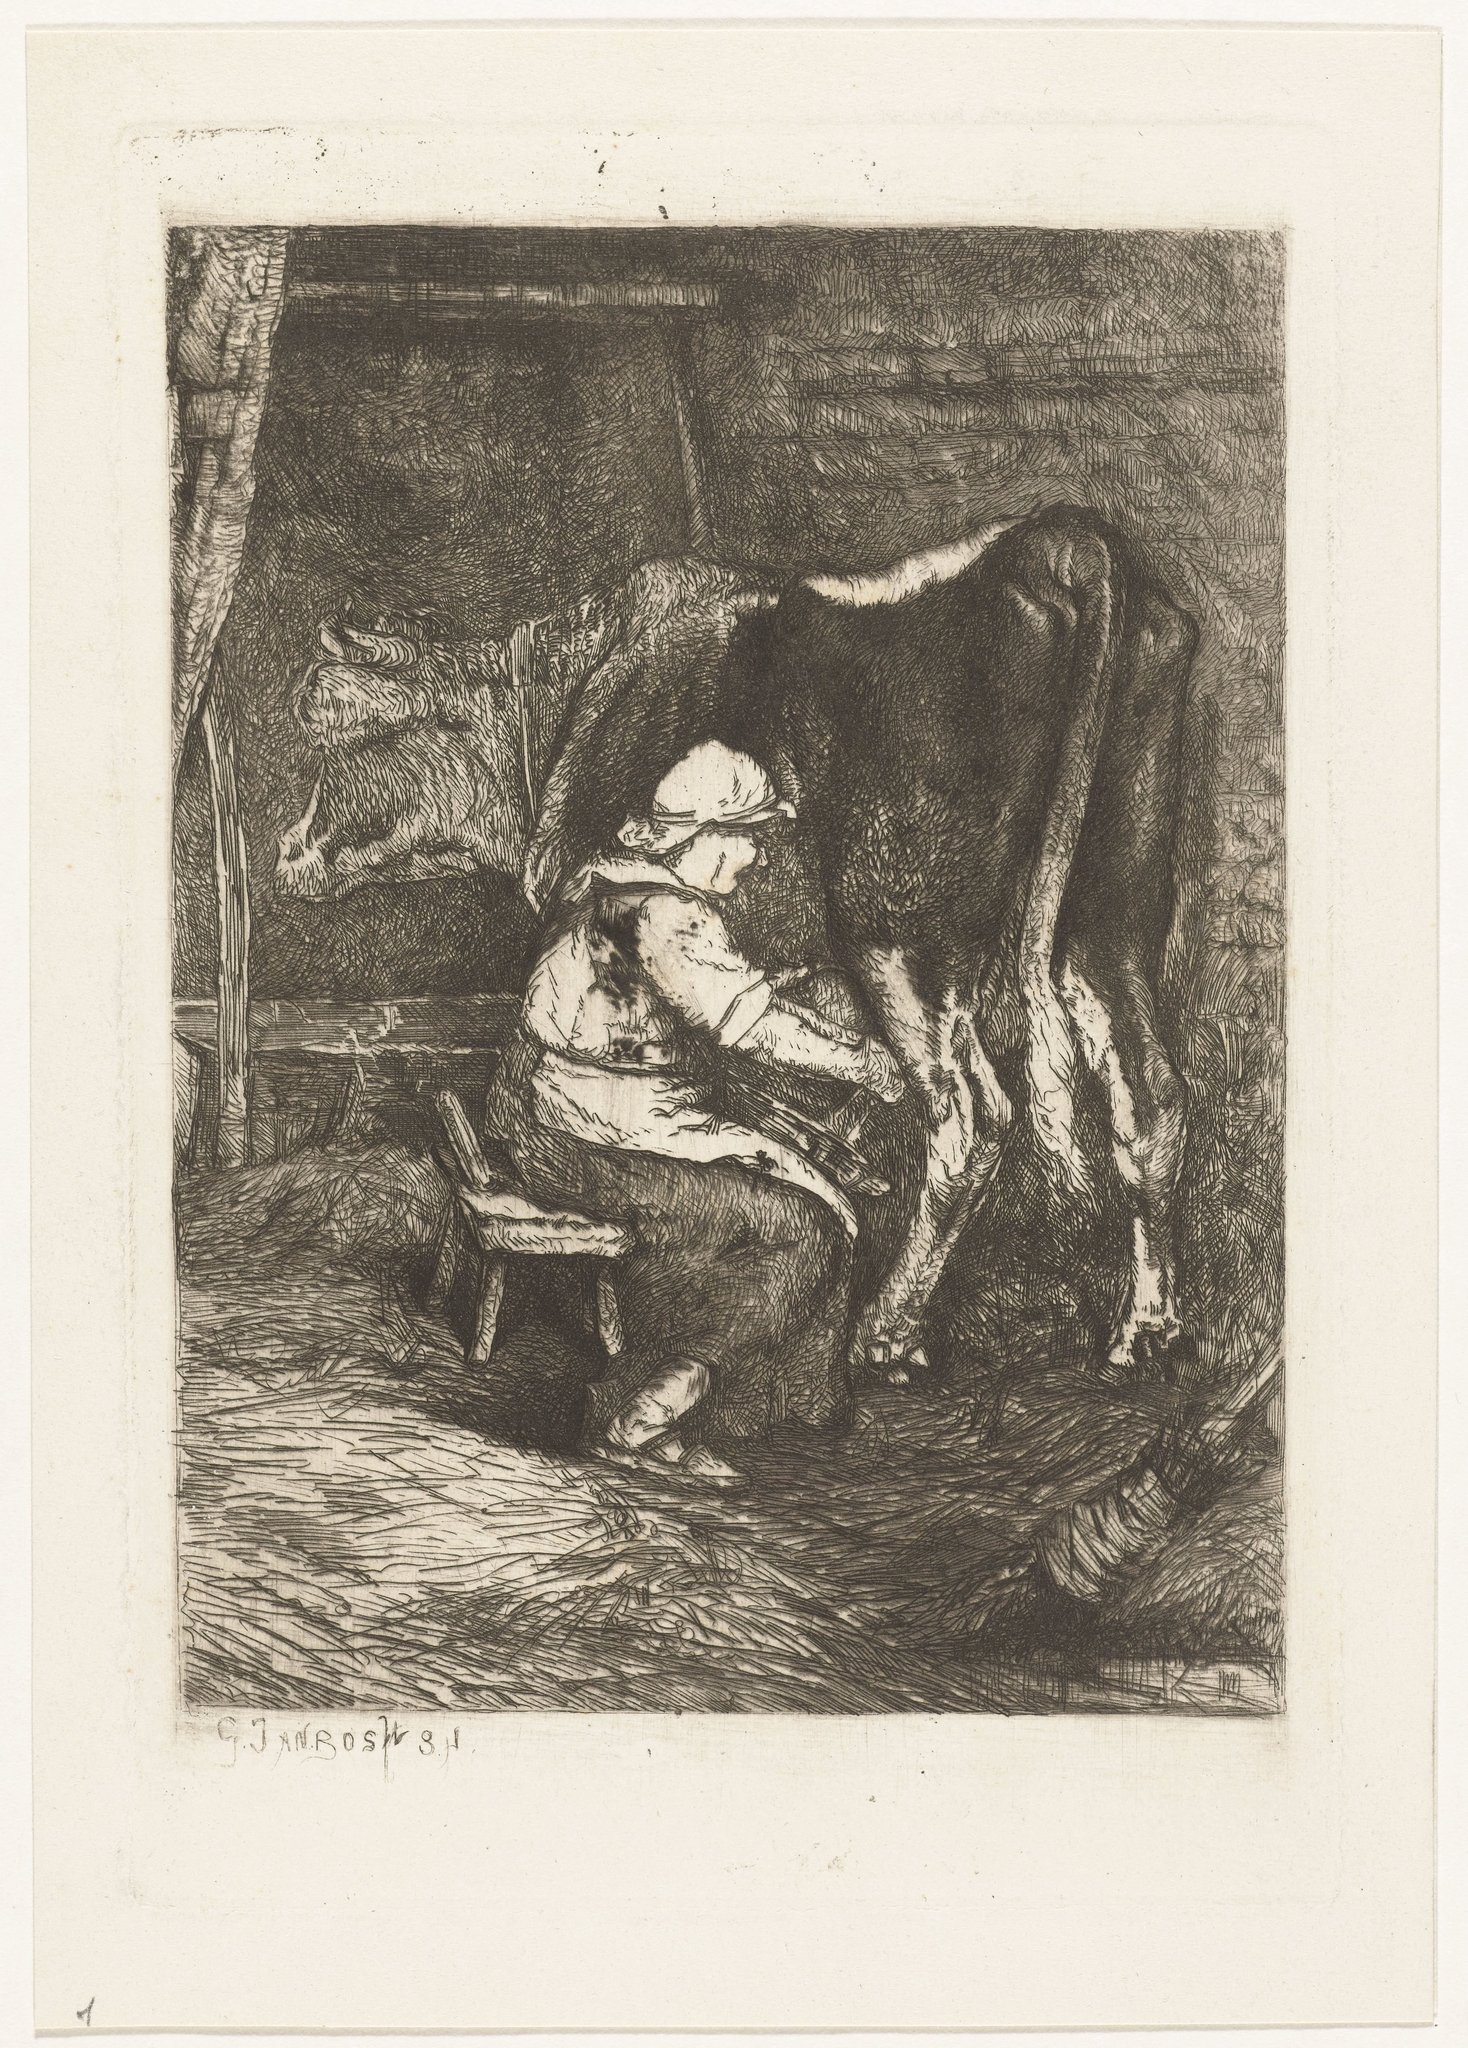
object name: print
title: Een koe wordt in de stal gemolken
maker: gerard jan bos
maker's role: print maker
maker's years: 1860-1943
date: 1884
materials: paper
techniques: drypoint, etching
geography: antwerp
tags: milking (+ indoors; in laboratory, factory, barn, etc.)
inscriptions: collector's mark: Lugt 2228